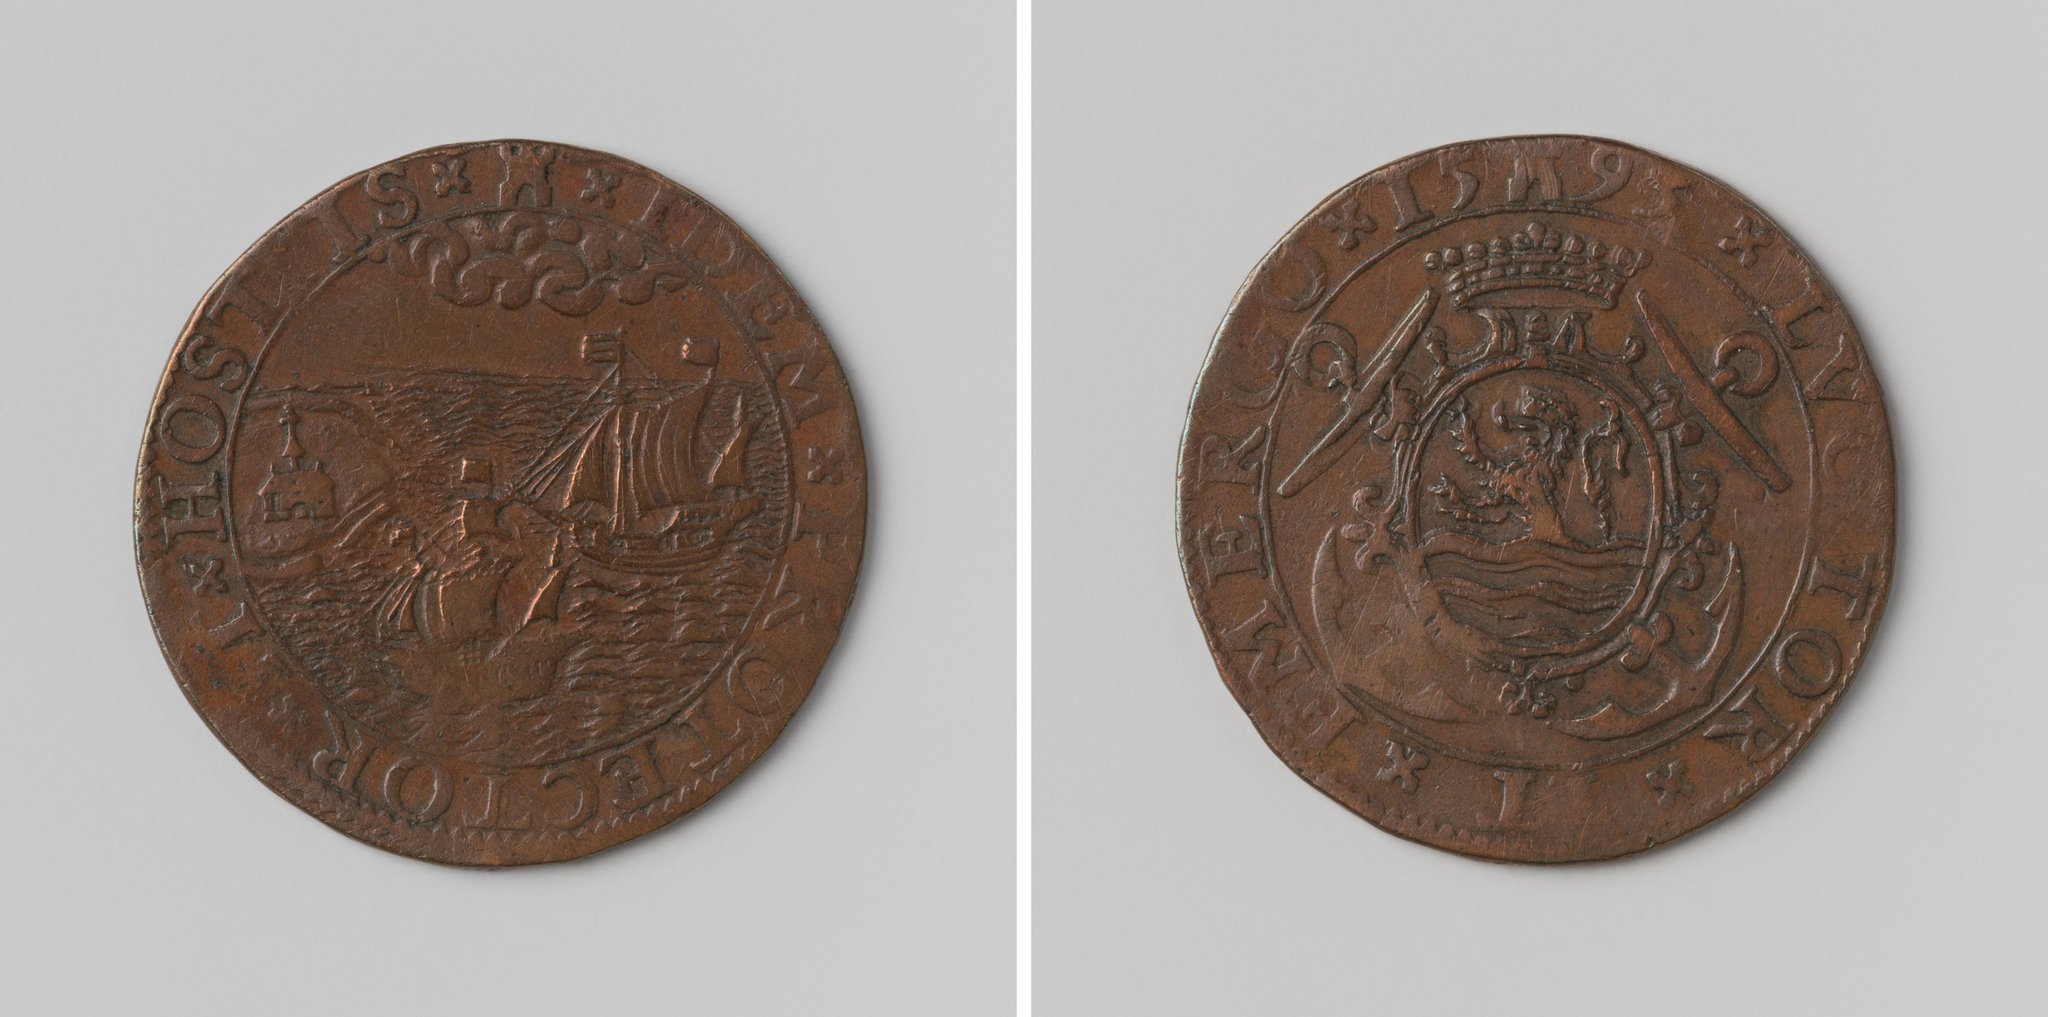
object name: jeton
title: Storm aan de Hollandse en Zeeuwse kusten, rekenpenning van de Staten van Zeeland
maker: Anonymous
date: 1593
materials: copper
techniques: striking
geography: middelburg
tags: zeeland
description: Koperen penning. Voorzijde: twee schepen voor eiland binnen omschrift. Keerzijde: gekroond wapenschild op twee gekruiste ankers binnen omschrift